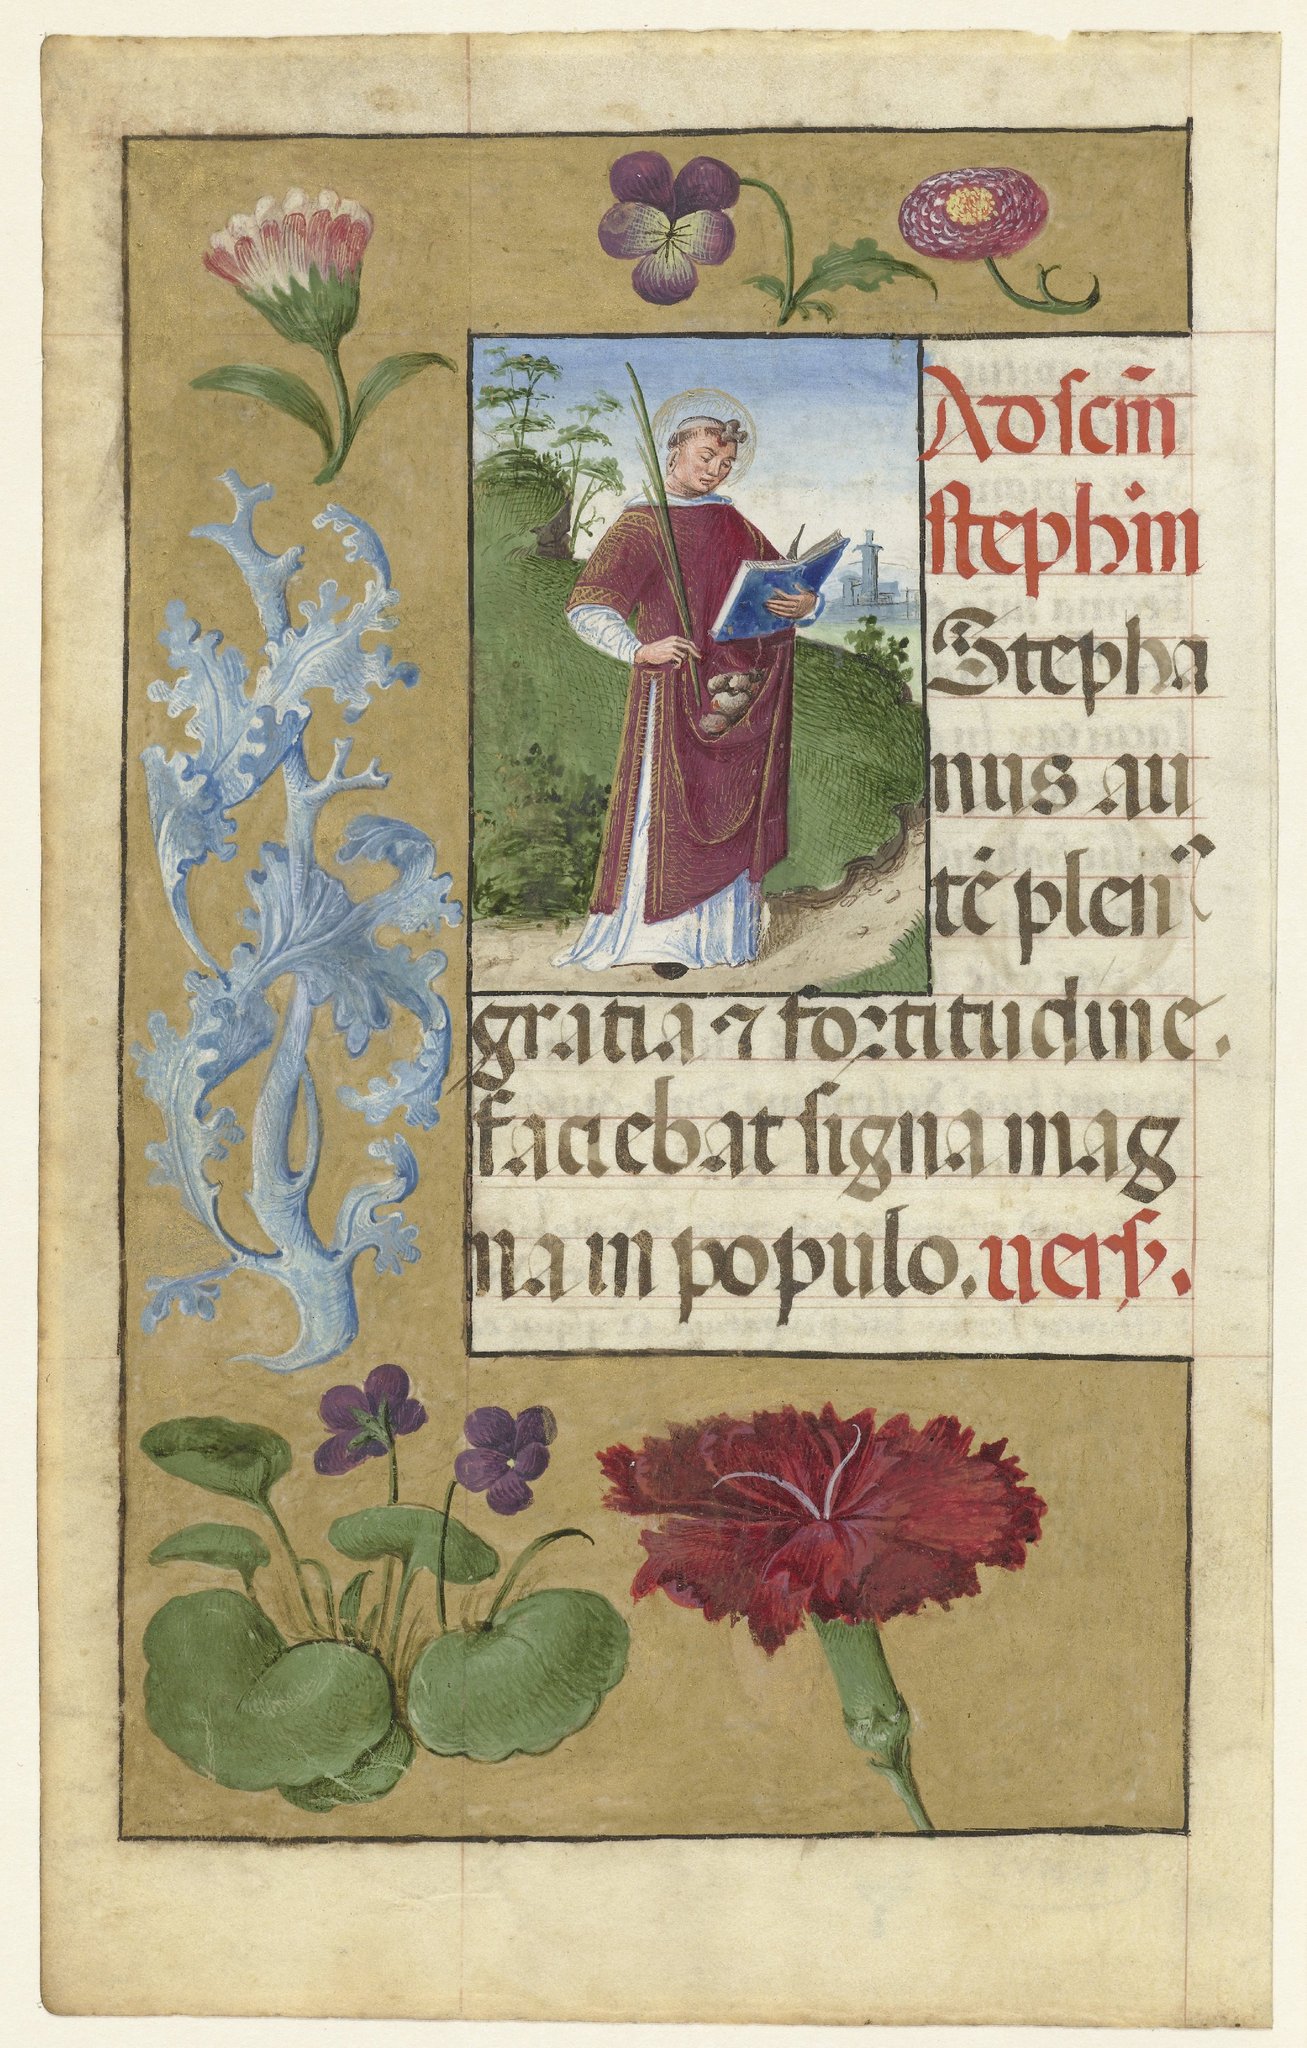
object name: drawing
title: De heilige Stephanus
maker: Anonymous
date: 1400-1499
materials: gouache, parchment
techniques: brush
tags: flowers, the deacon and (proto)martyr stephen; possible attributes: censer, stones